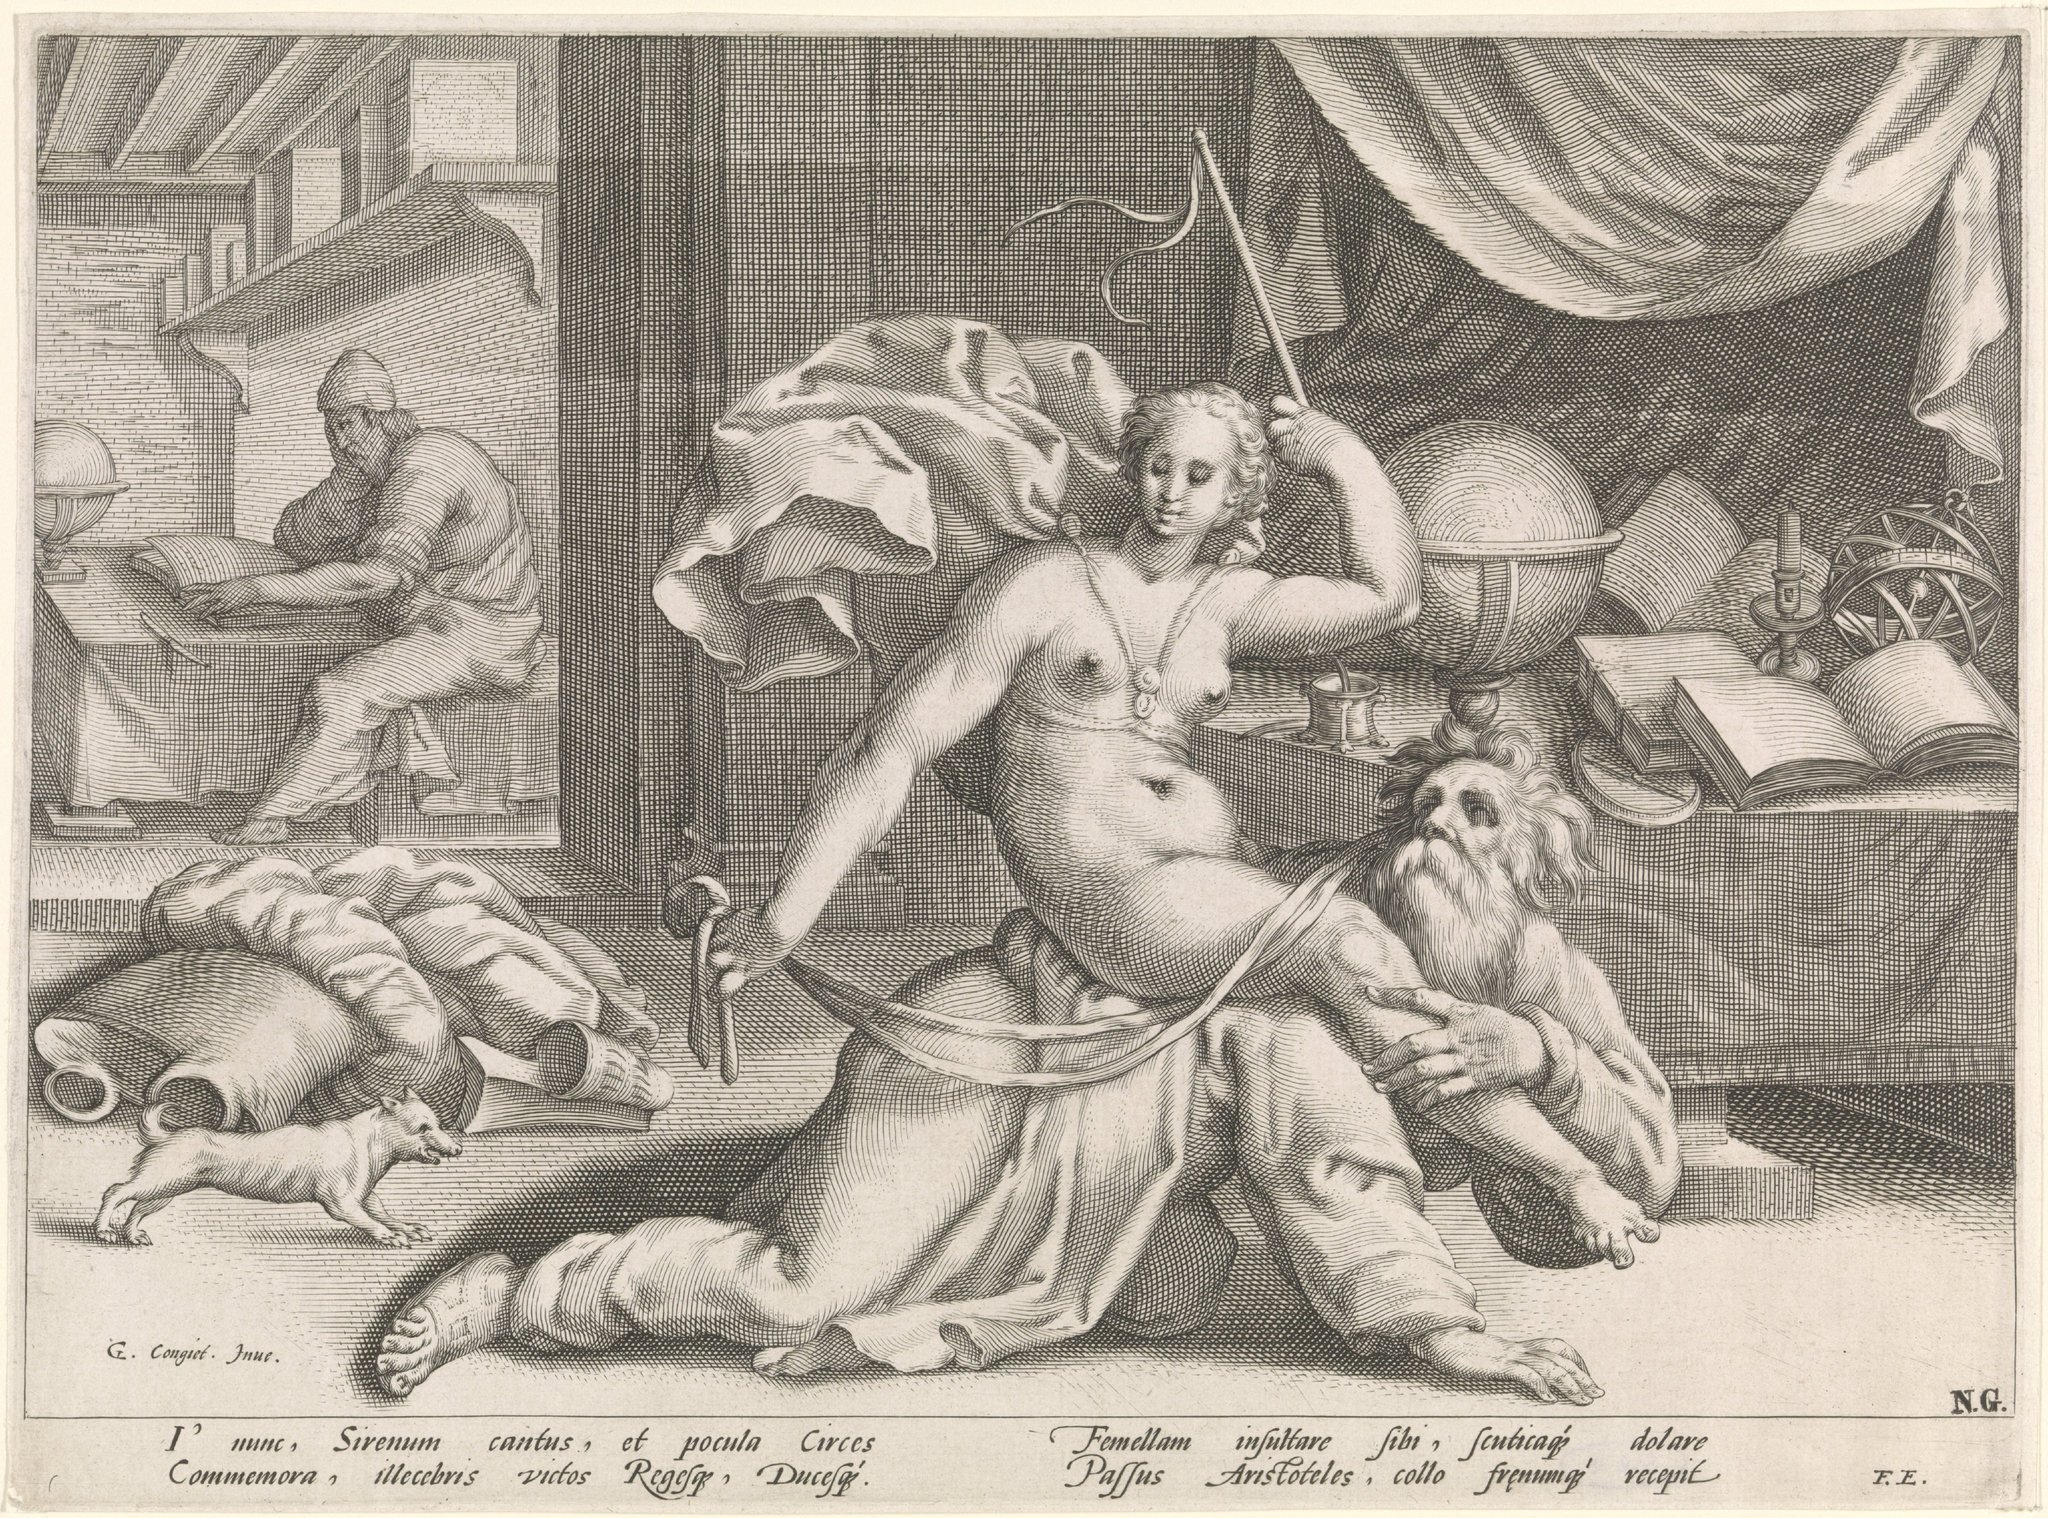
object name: print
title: Aristoteles en Phyllis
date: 1588-1592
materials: paper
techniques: engraving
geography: antwerp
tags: aristotle and phyllis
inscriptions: collector's mark: Lugt 2228, collector's mark: Lugt 1967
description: Phyllis, van haar kleding ontdaan, berijdt Aristoteles die op handen en voeten rondkruipt in een studeervertrek. Rechts een tafel, waarop een aard- en een hemelglobe, boeken, inktkoker, en een kandelaar. Links op de achtergrond Op de achtergrond Aristoteles als geleerde.